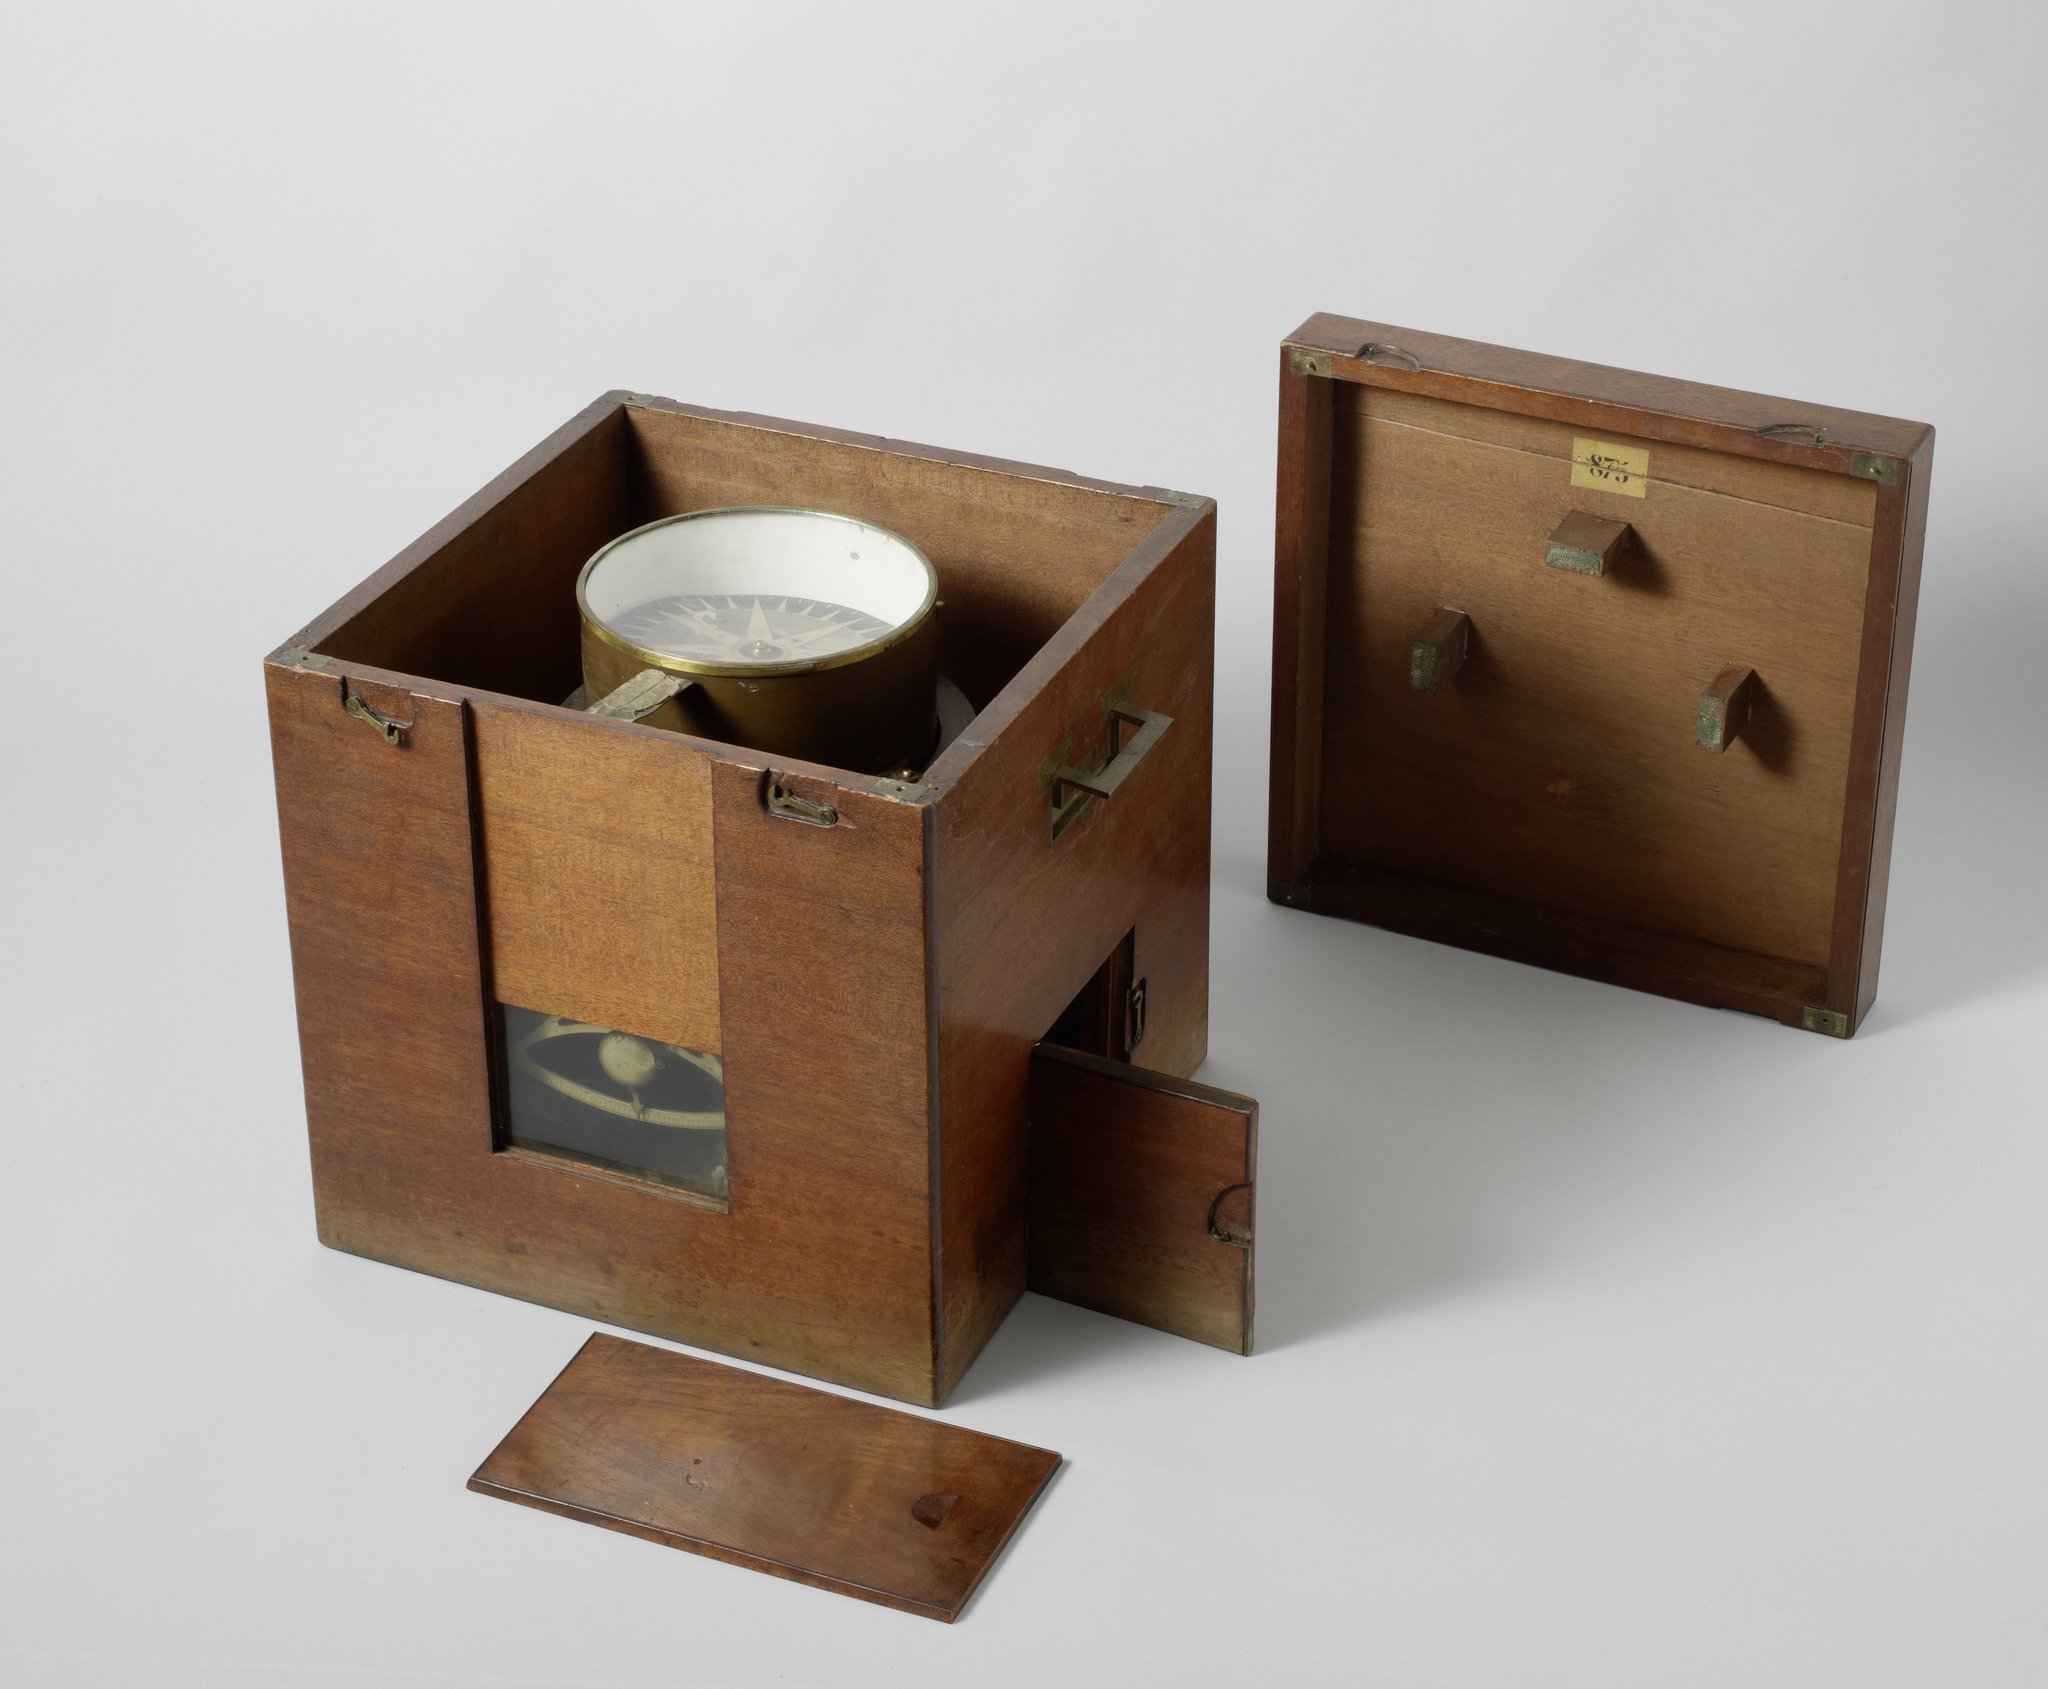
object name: scheepskompas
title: Ship Compass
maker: c. phillips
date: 1825-1829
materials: stone, brass, copper, iron, lacquer, lead, paper, gemstone, wood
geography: united kingdom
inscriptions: inscription, on the compass card: ‘Captn C. Phillips, R.N. / Bramah & Sons.London.fecit.’